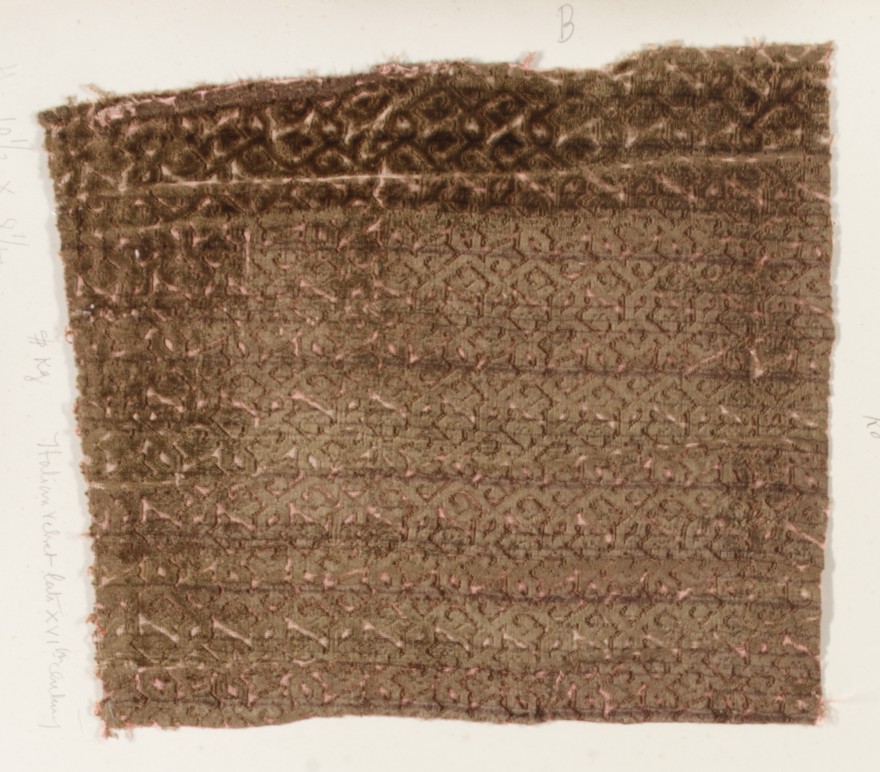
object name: fragment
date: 1501-1600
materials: silk